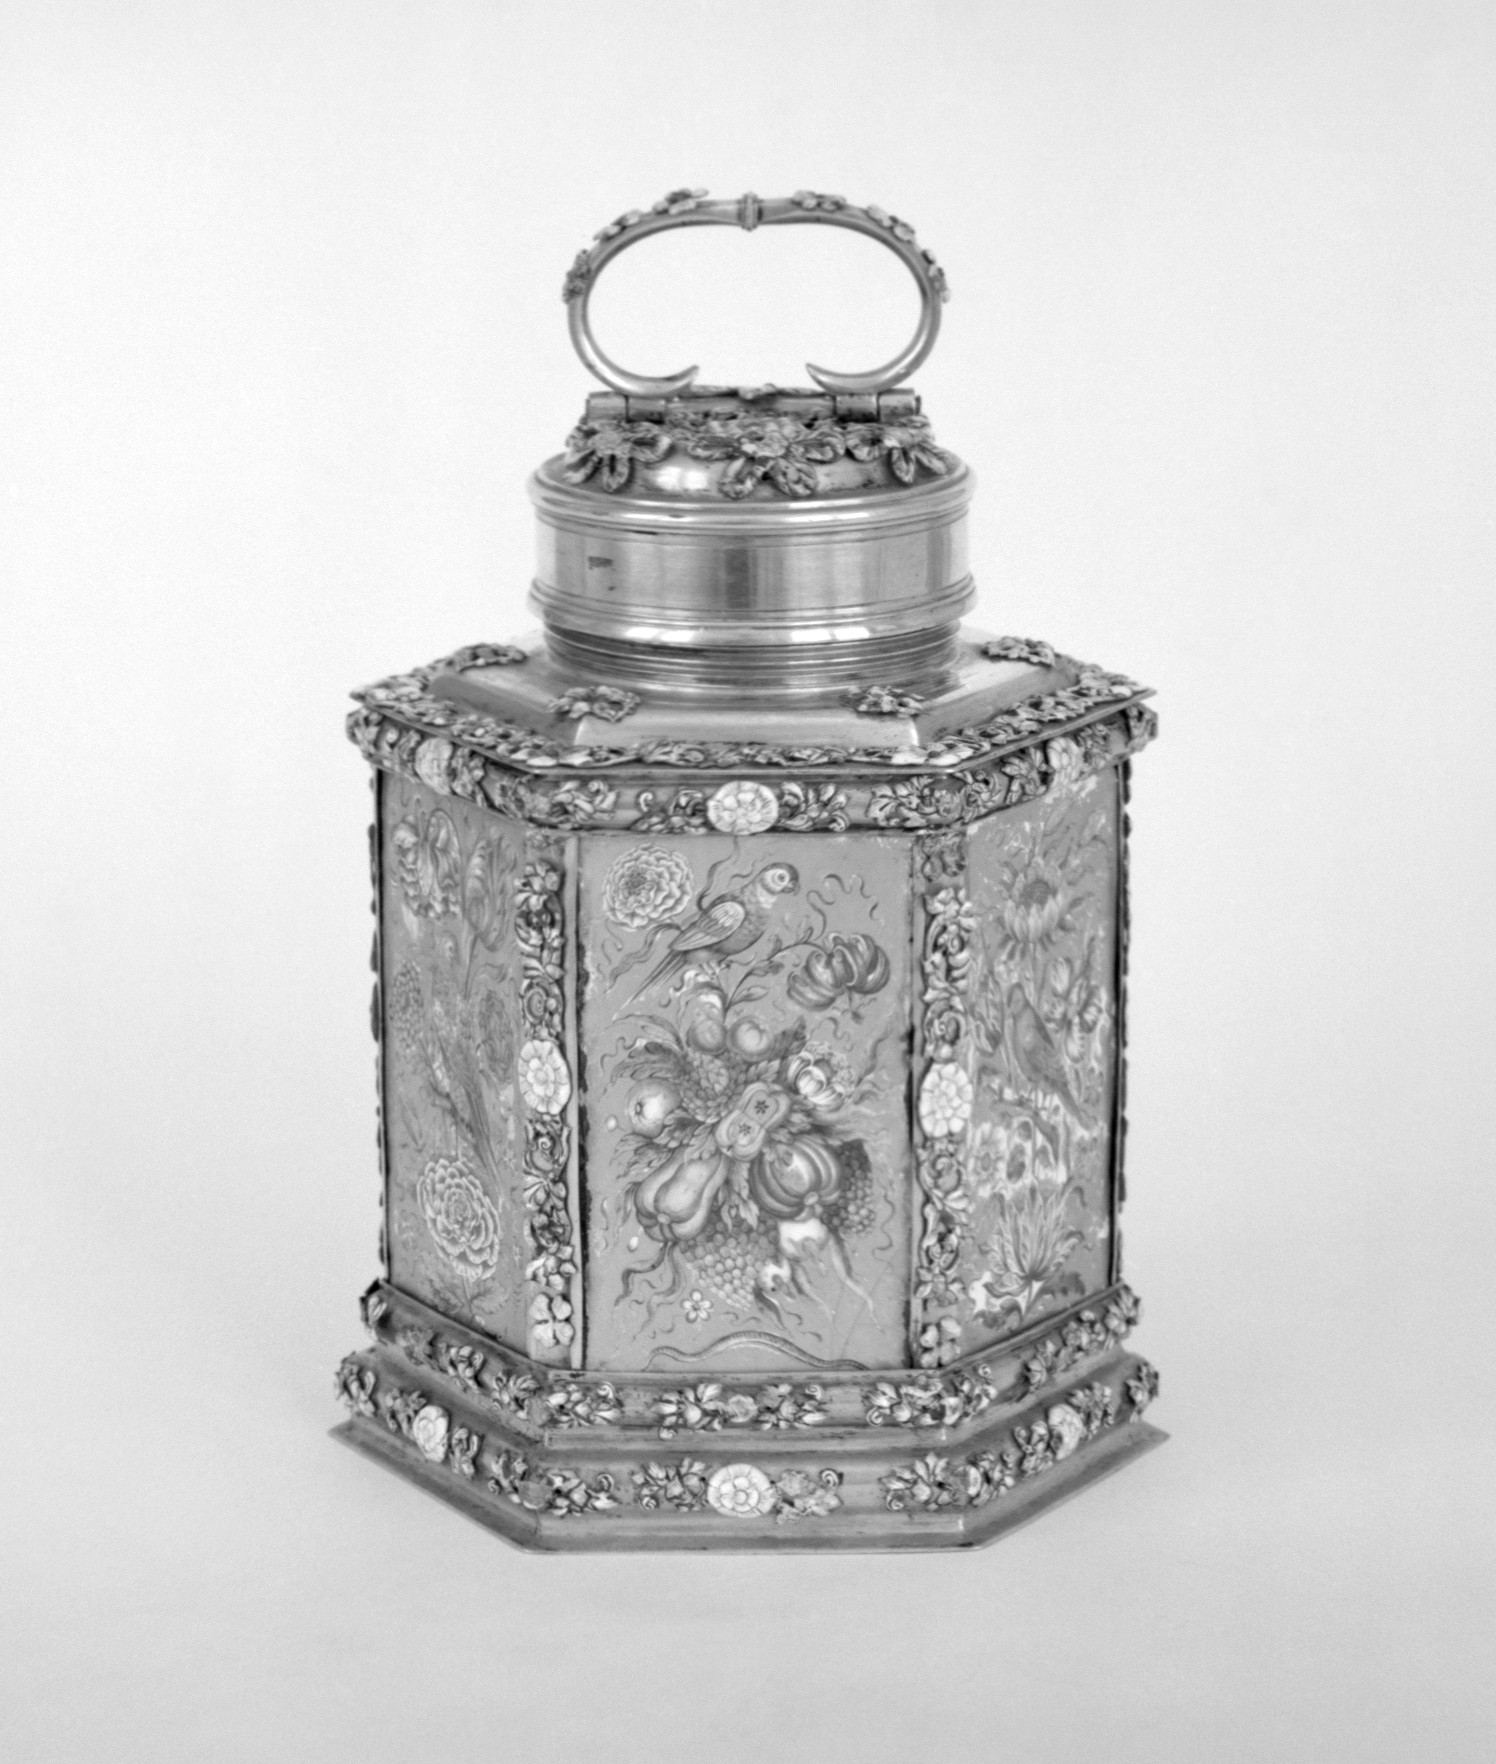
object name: canister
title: Hexagonal canister (Schraubflasche)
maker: jonas laminit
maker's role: maker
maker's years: 1590-1690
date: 1650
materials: enamel, silver gilt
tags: birds,fruit,flowers